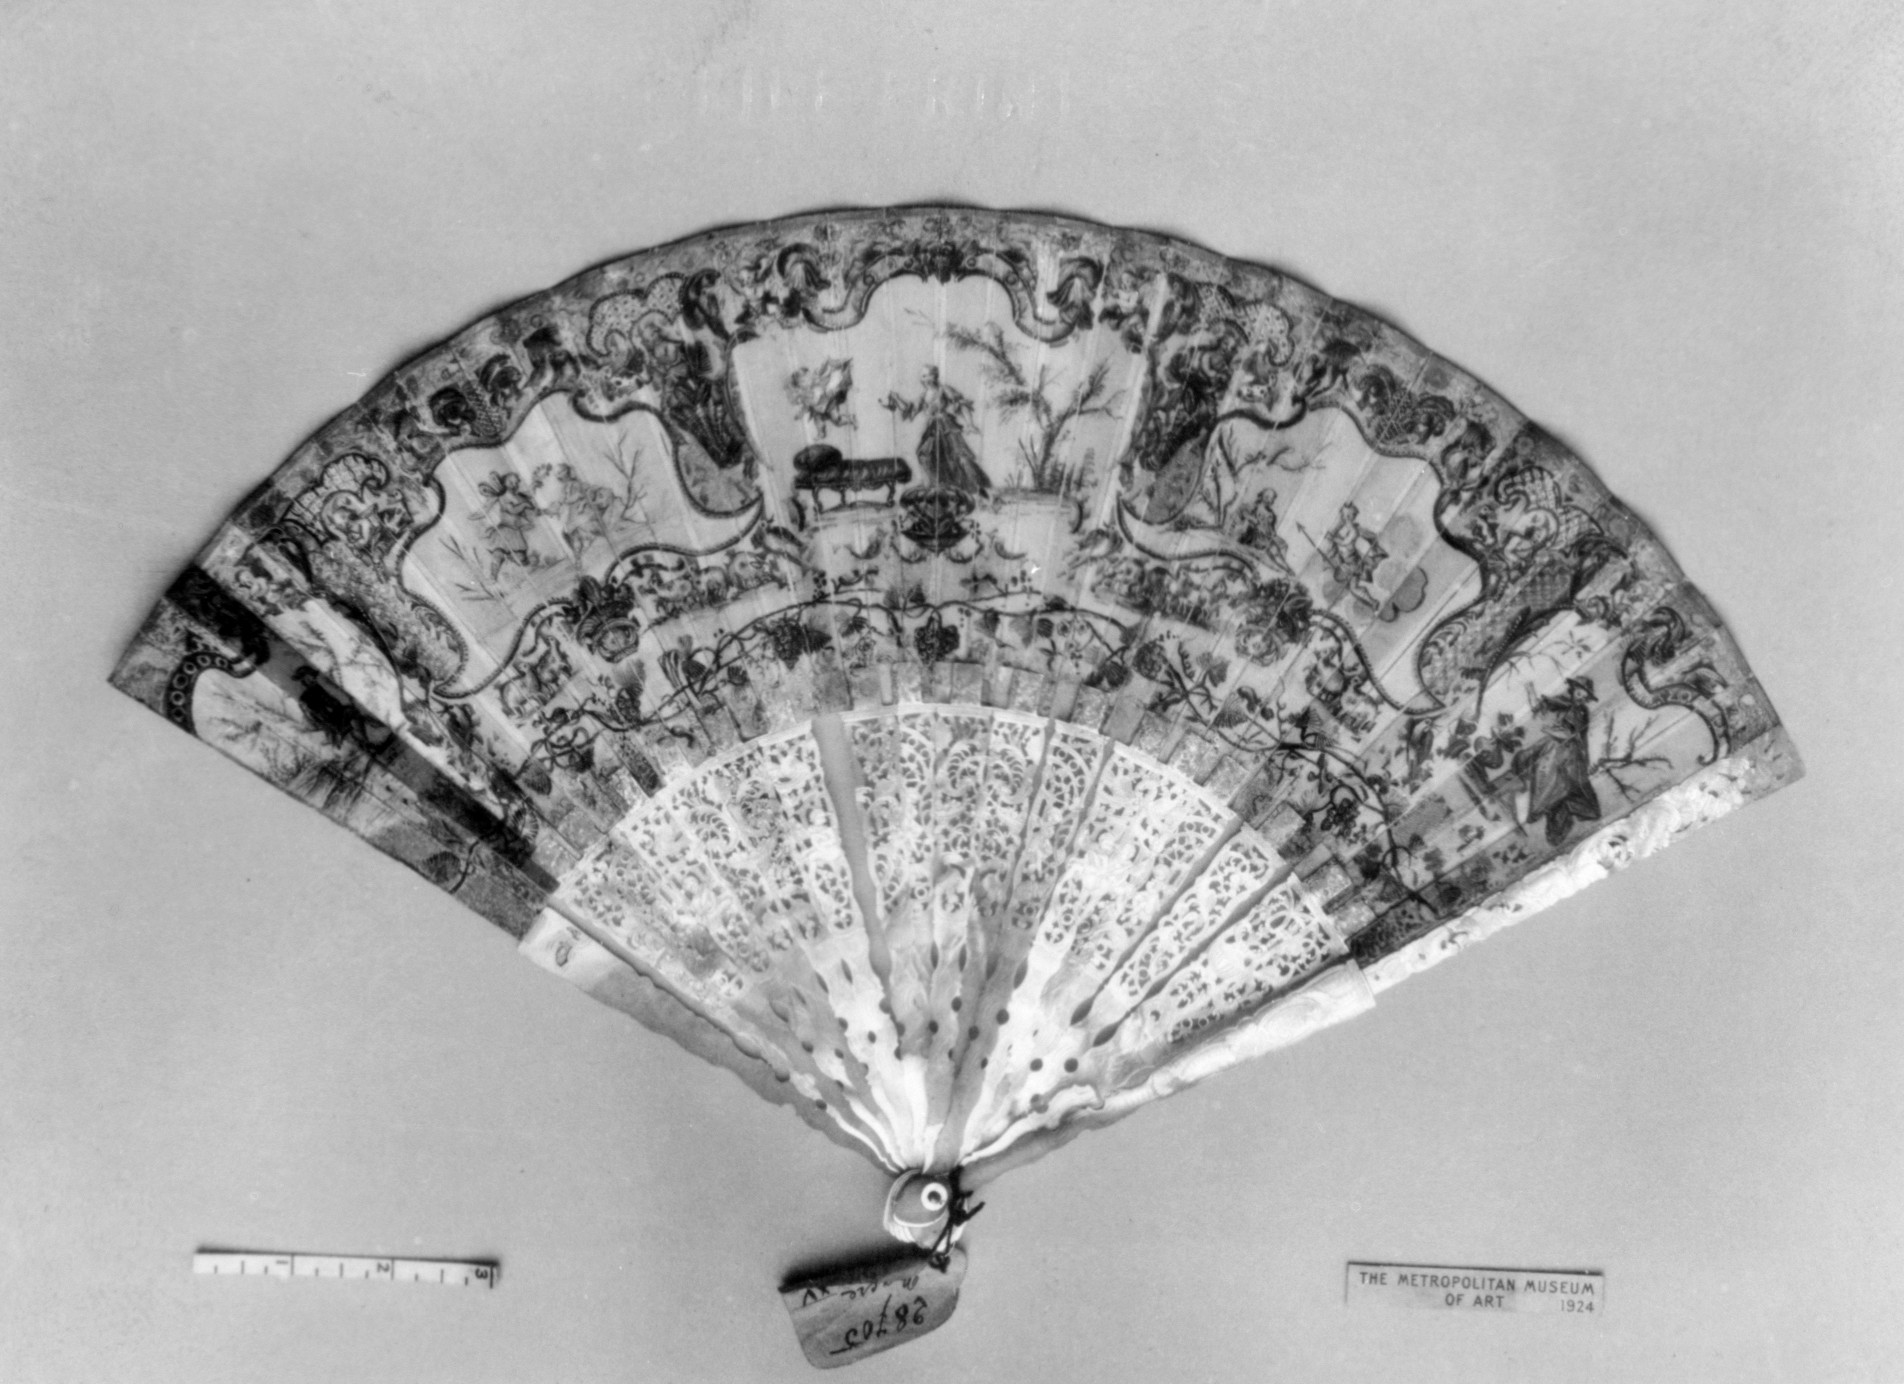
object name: fan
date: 1701-1733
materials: ivory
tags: women